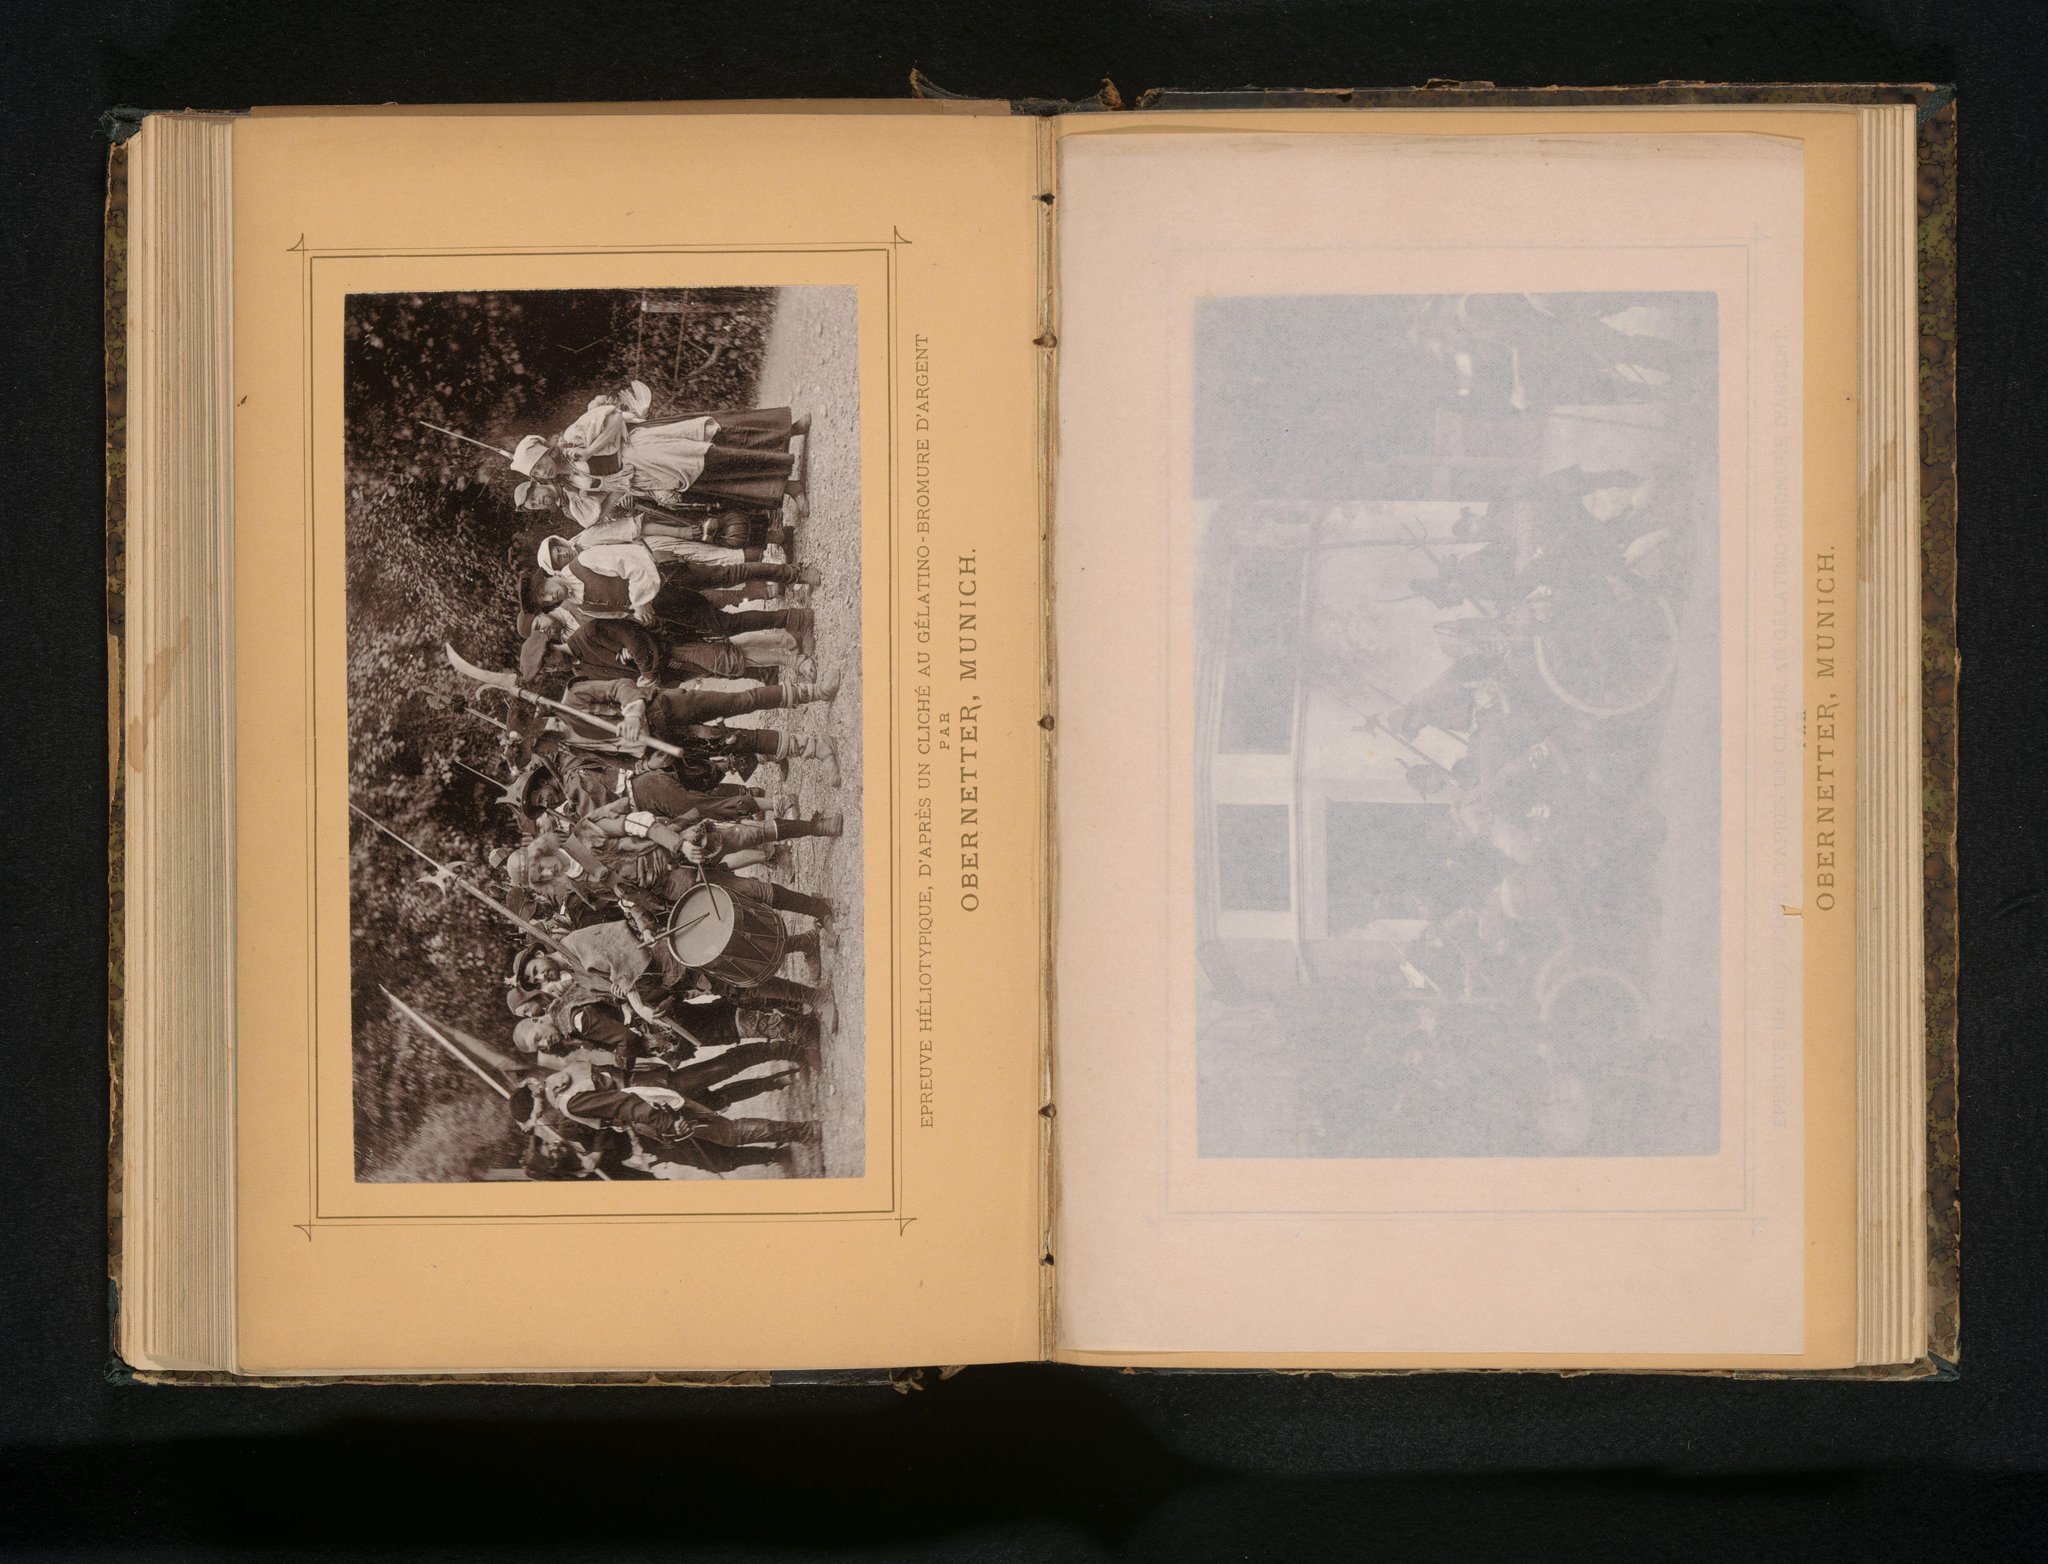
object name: photomechanical print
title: Gezicht op een groep onbekende personen waarvan één met een trommel die vermoedelijk een strijd of slag naspelen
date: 1884-1889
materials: paper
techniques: photograph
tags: historical persons, drum (musical instrument) - cc - out of doors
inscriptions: inscription: ‘Épreuve héliotypique, d'après un cliché au gélatino-bromure d'argent/ par/ Obernetter, Munich’